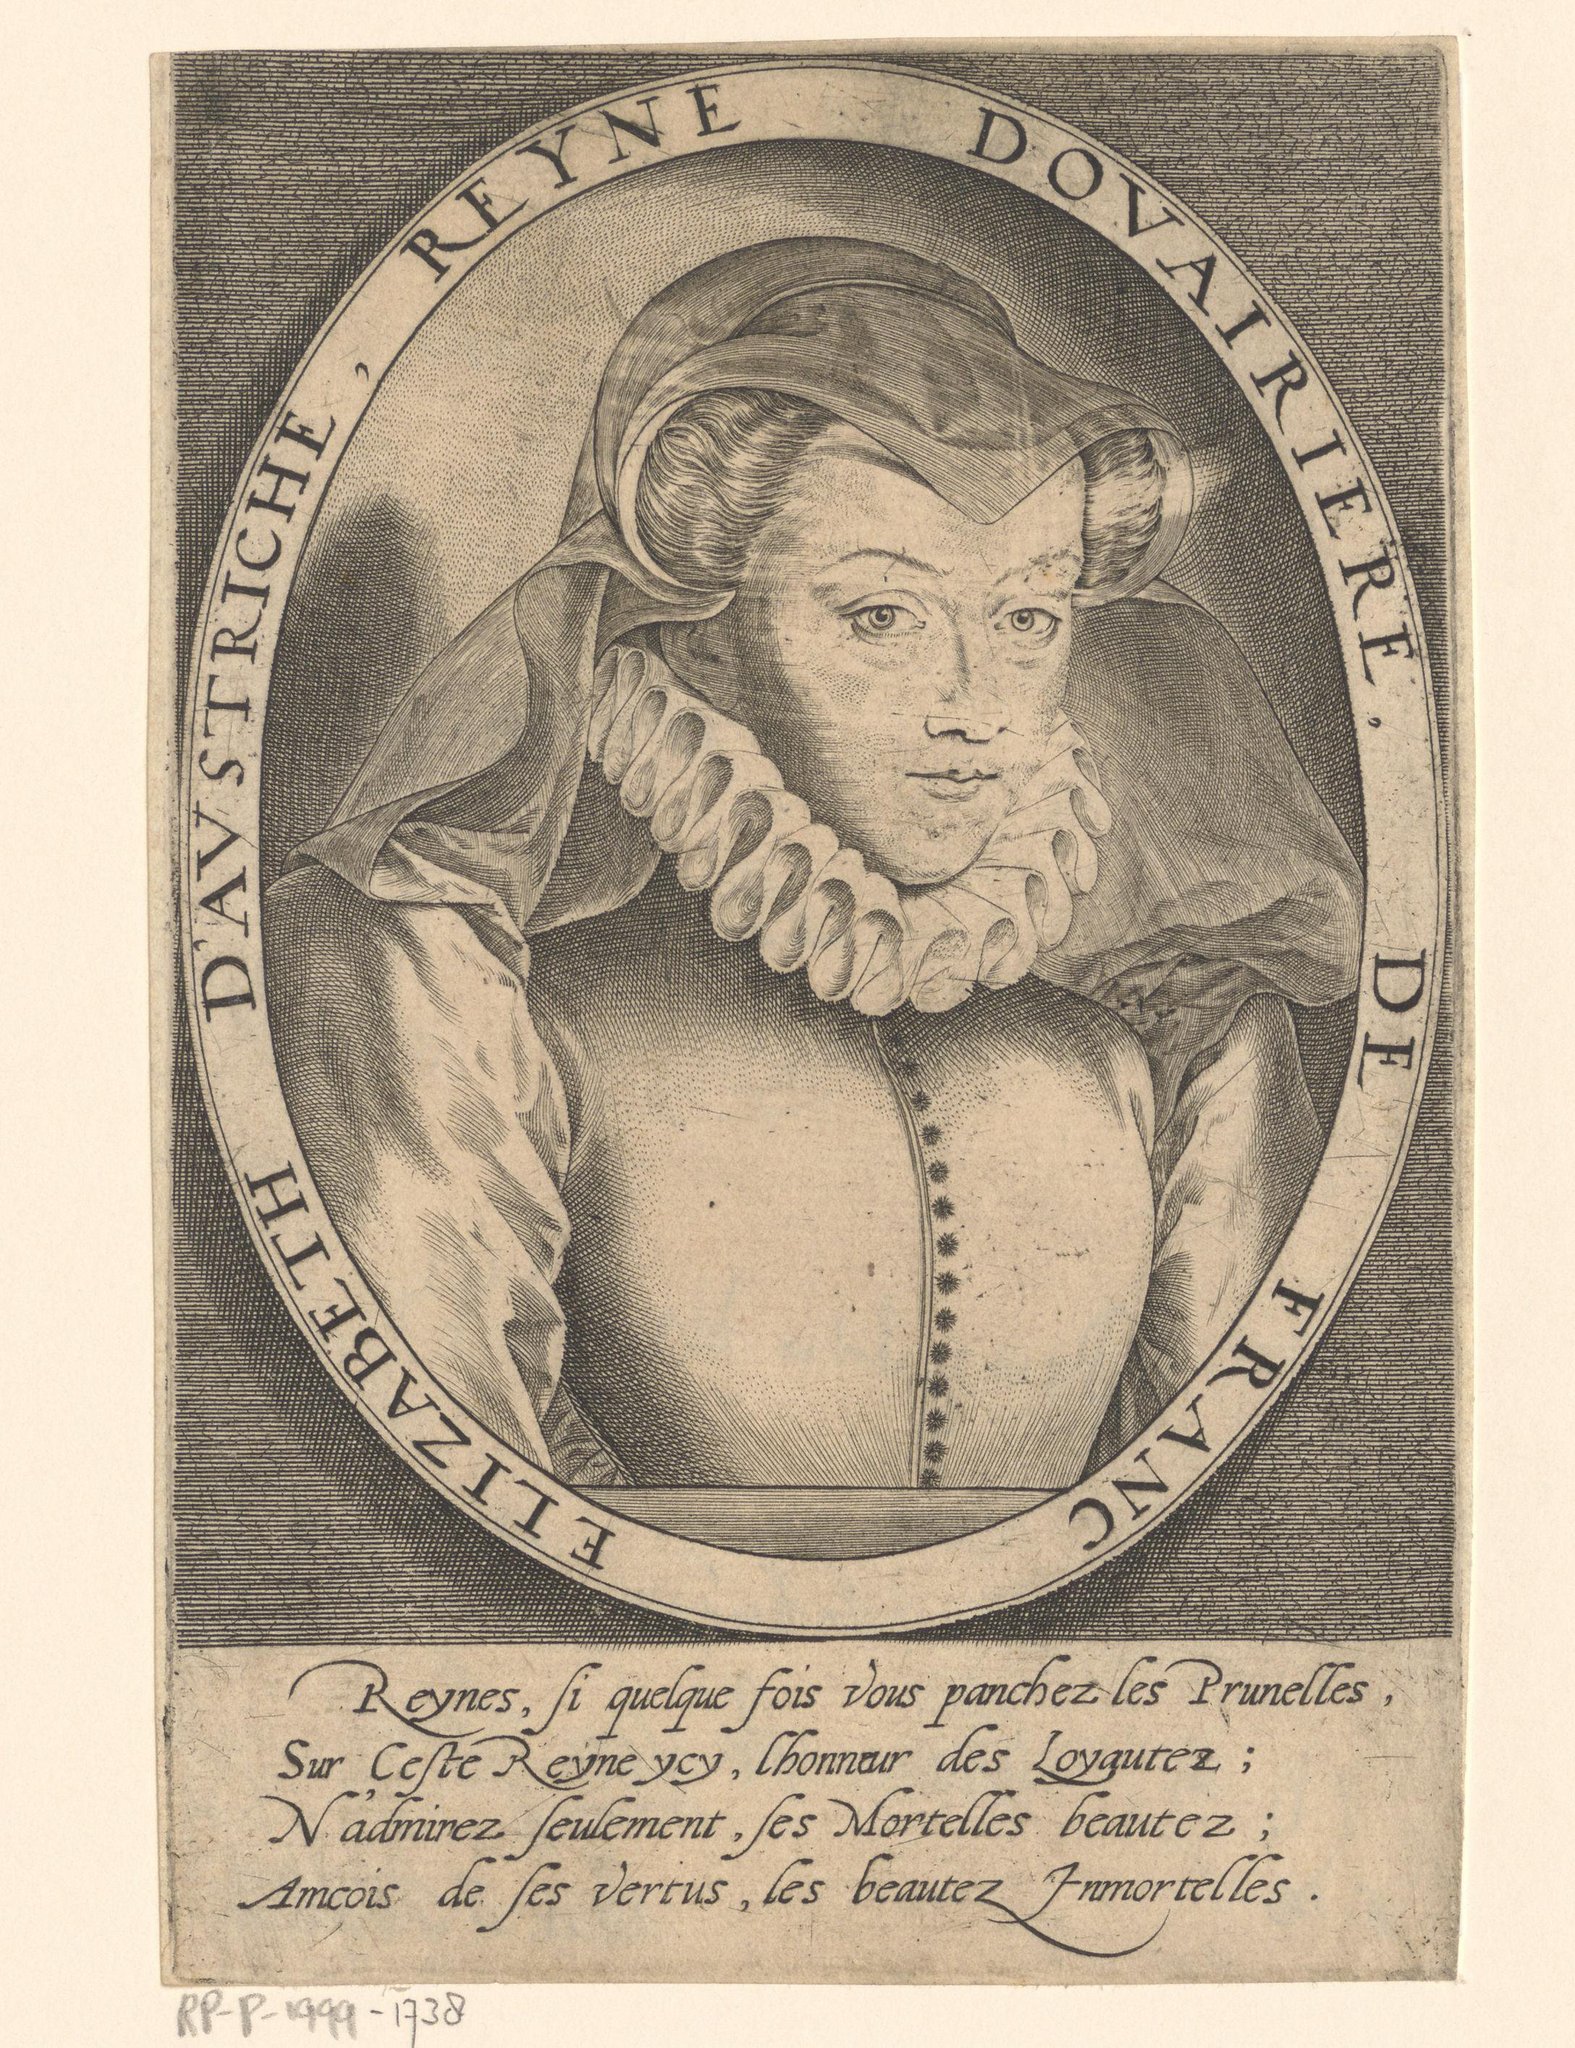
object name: print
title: Portret van Elisabeth van Oostenrijk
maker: thomas de leu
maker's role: print maker, publisher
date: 1587-1590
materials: paper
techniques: engraving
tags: vienna, historical persons - bb - woman, queen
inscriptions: collector's mark: Lugt 2228